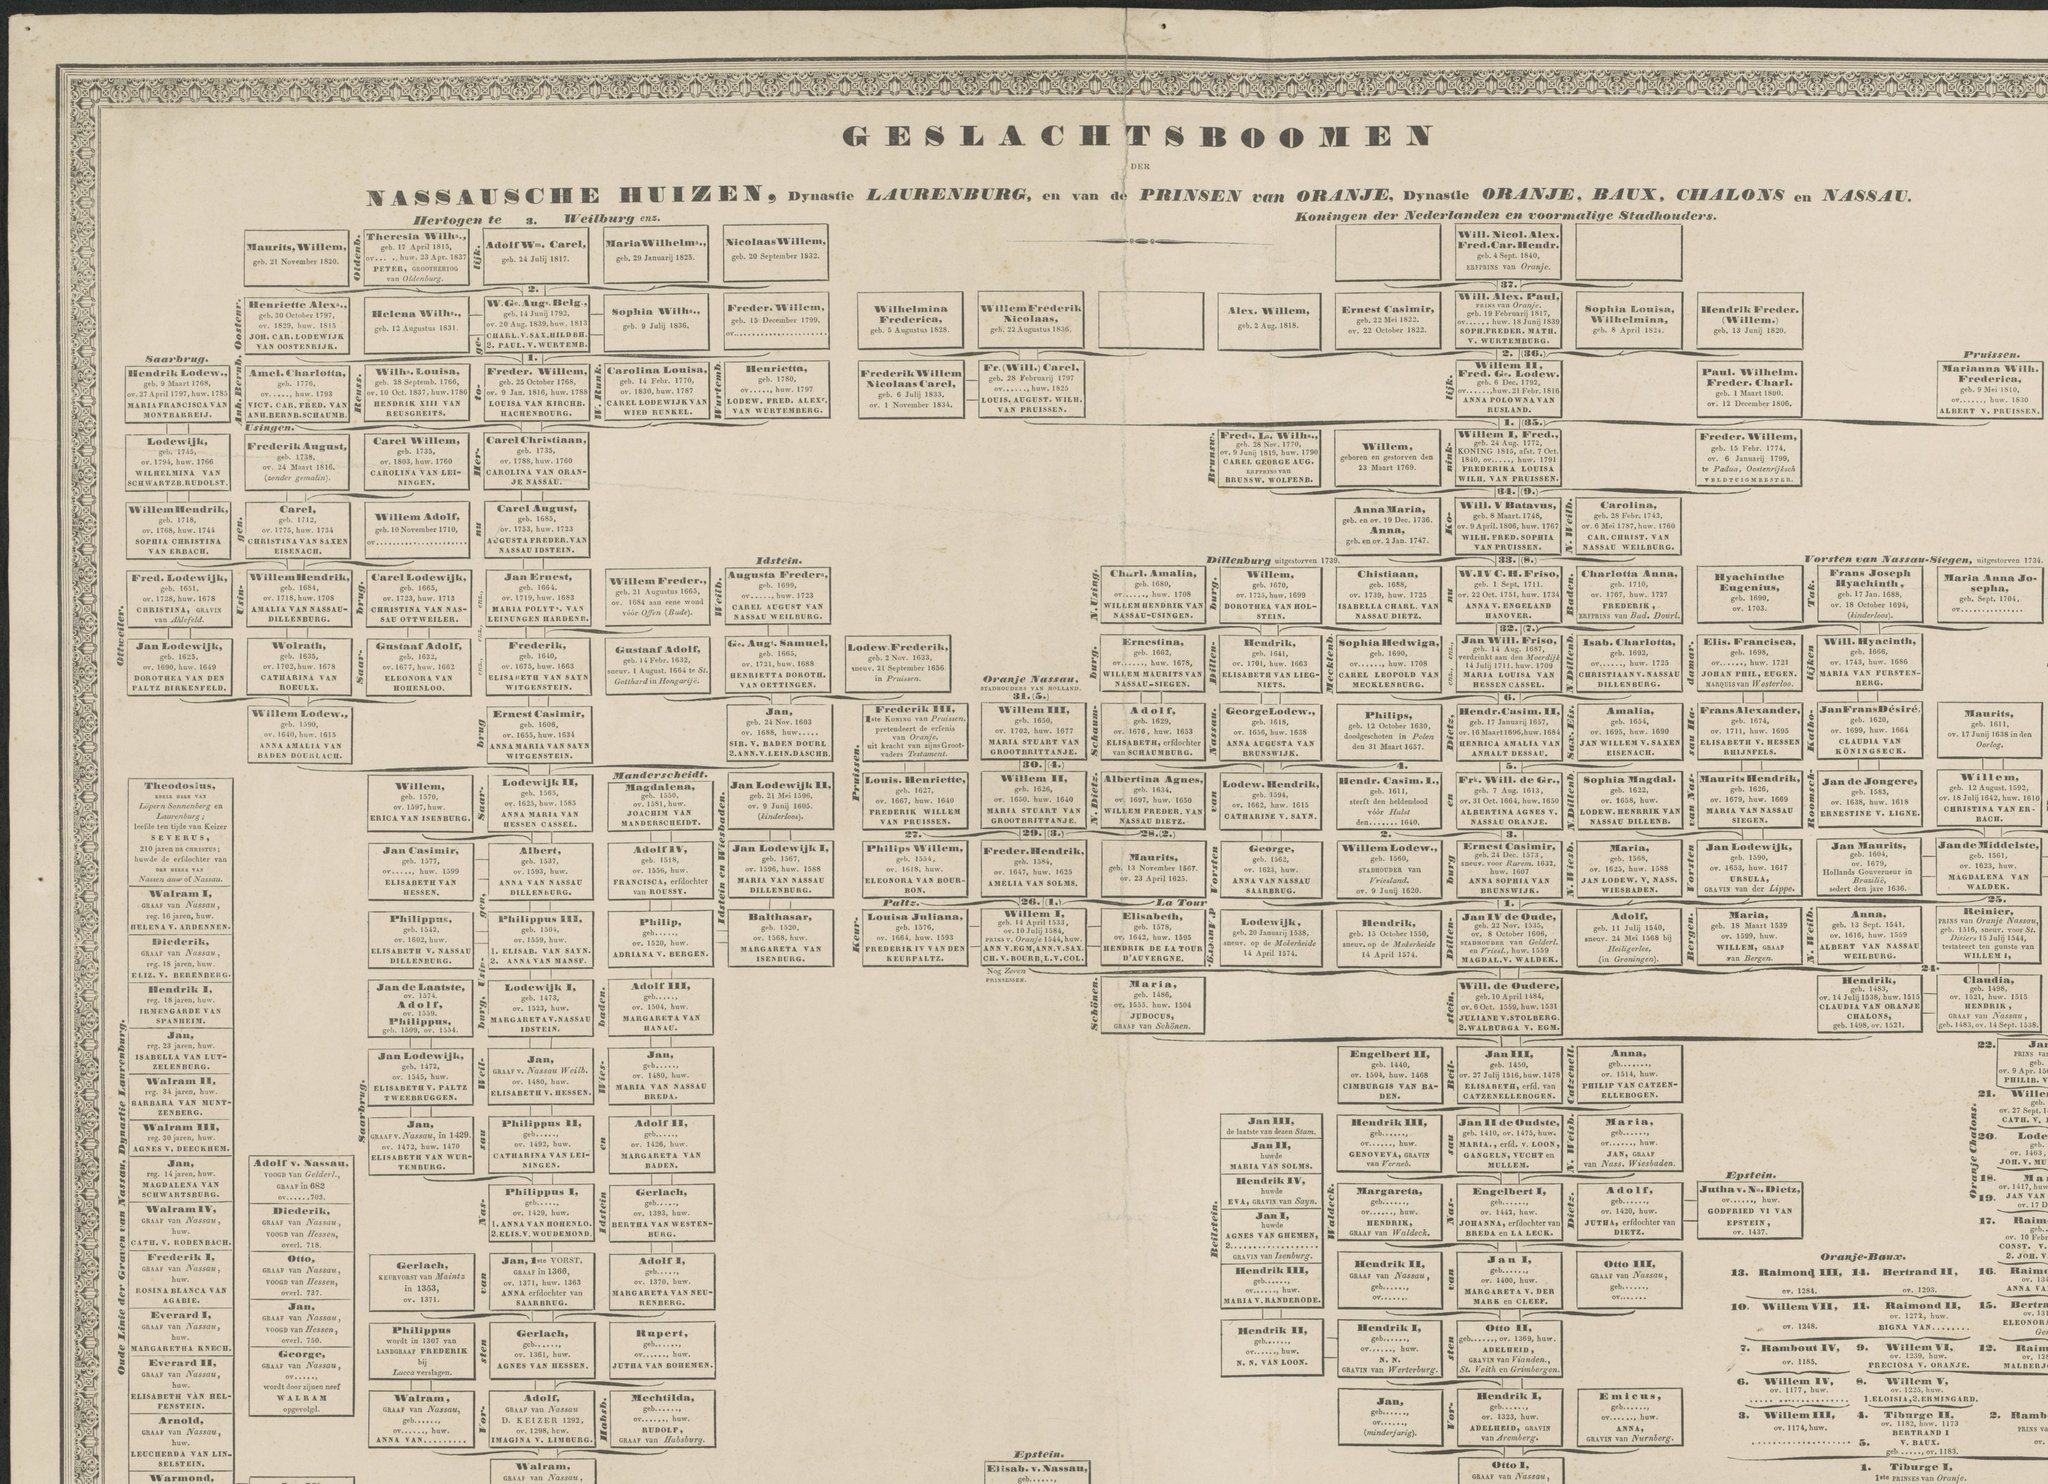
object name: print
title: Stamboom van het Huis Nassau en de prinsen van Oranje van de Huizen Orange, Baux, Châlon en Nassau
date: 1840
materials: paper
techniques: engraving, etching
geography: haarlem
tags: family lineage, pedigree, genealogical tree or table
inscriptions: collector's mark: Lugt 964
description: Stamboom van het Huis Nassau en de prinsen van Oranje van de Huizen Orange, Baux, Châlon en Nassau, van 210 tot en met 1840. In kaders namen, titels, geboortedata en sterfdata. Midden boven twee regels Nederlandse tekst. Geheel in een geornamenteerde rechthoek.